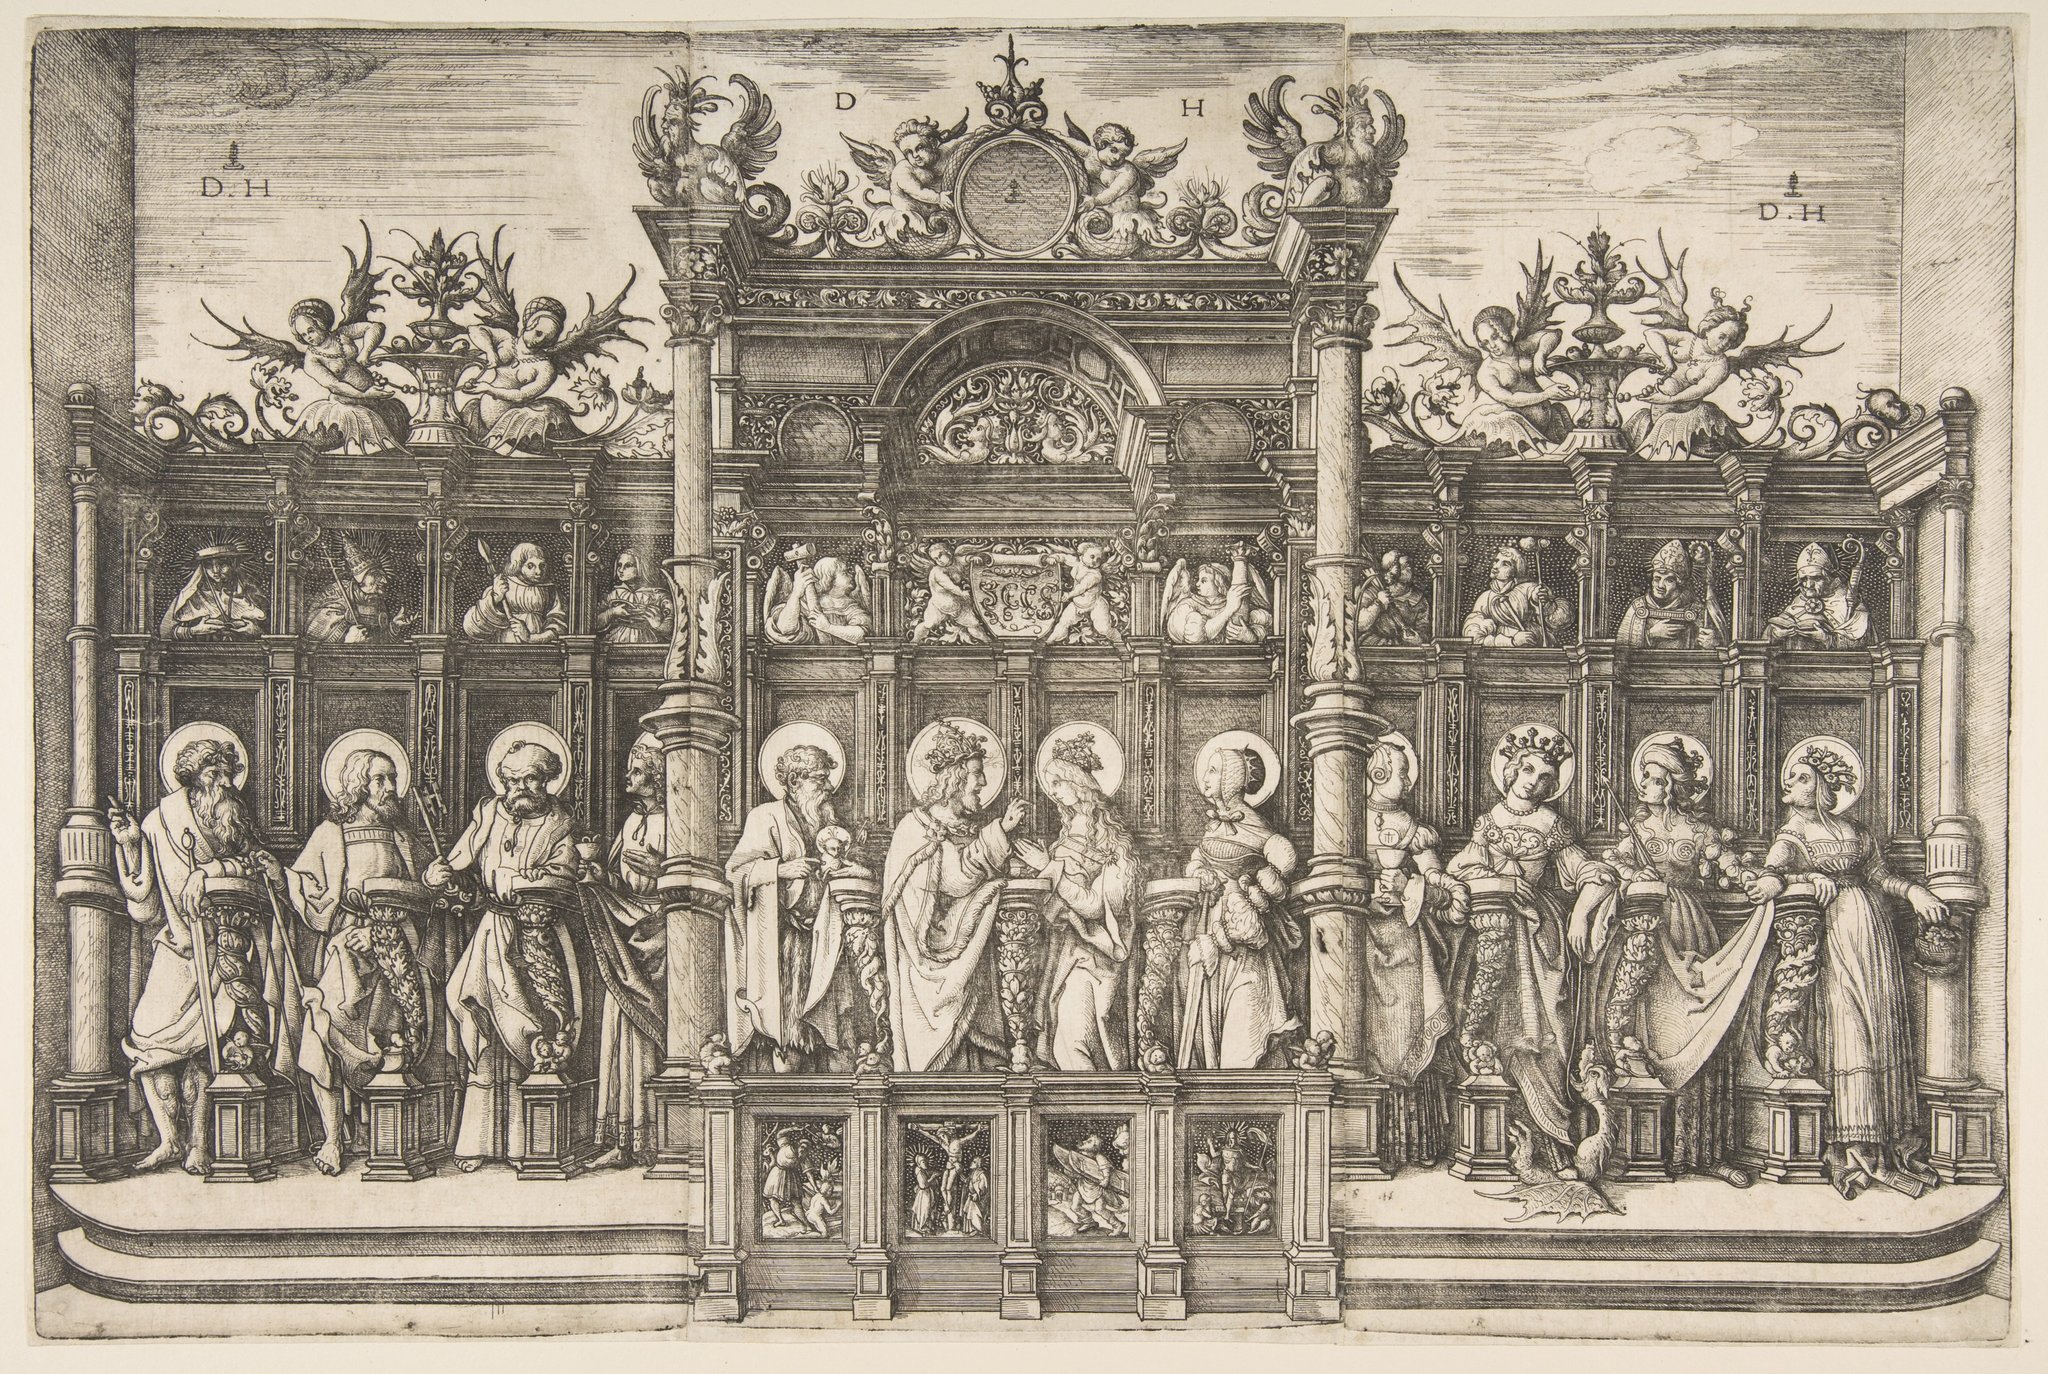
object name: print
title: Large Choirstall with Christ Blessing the Virgin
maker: daniel hopfer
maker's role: artist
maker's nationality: german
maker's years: 1470-1536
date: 1518-1520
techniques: etching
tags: men,women,angels,christ,virgin mary,saints